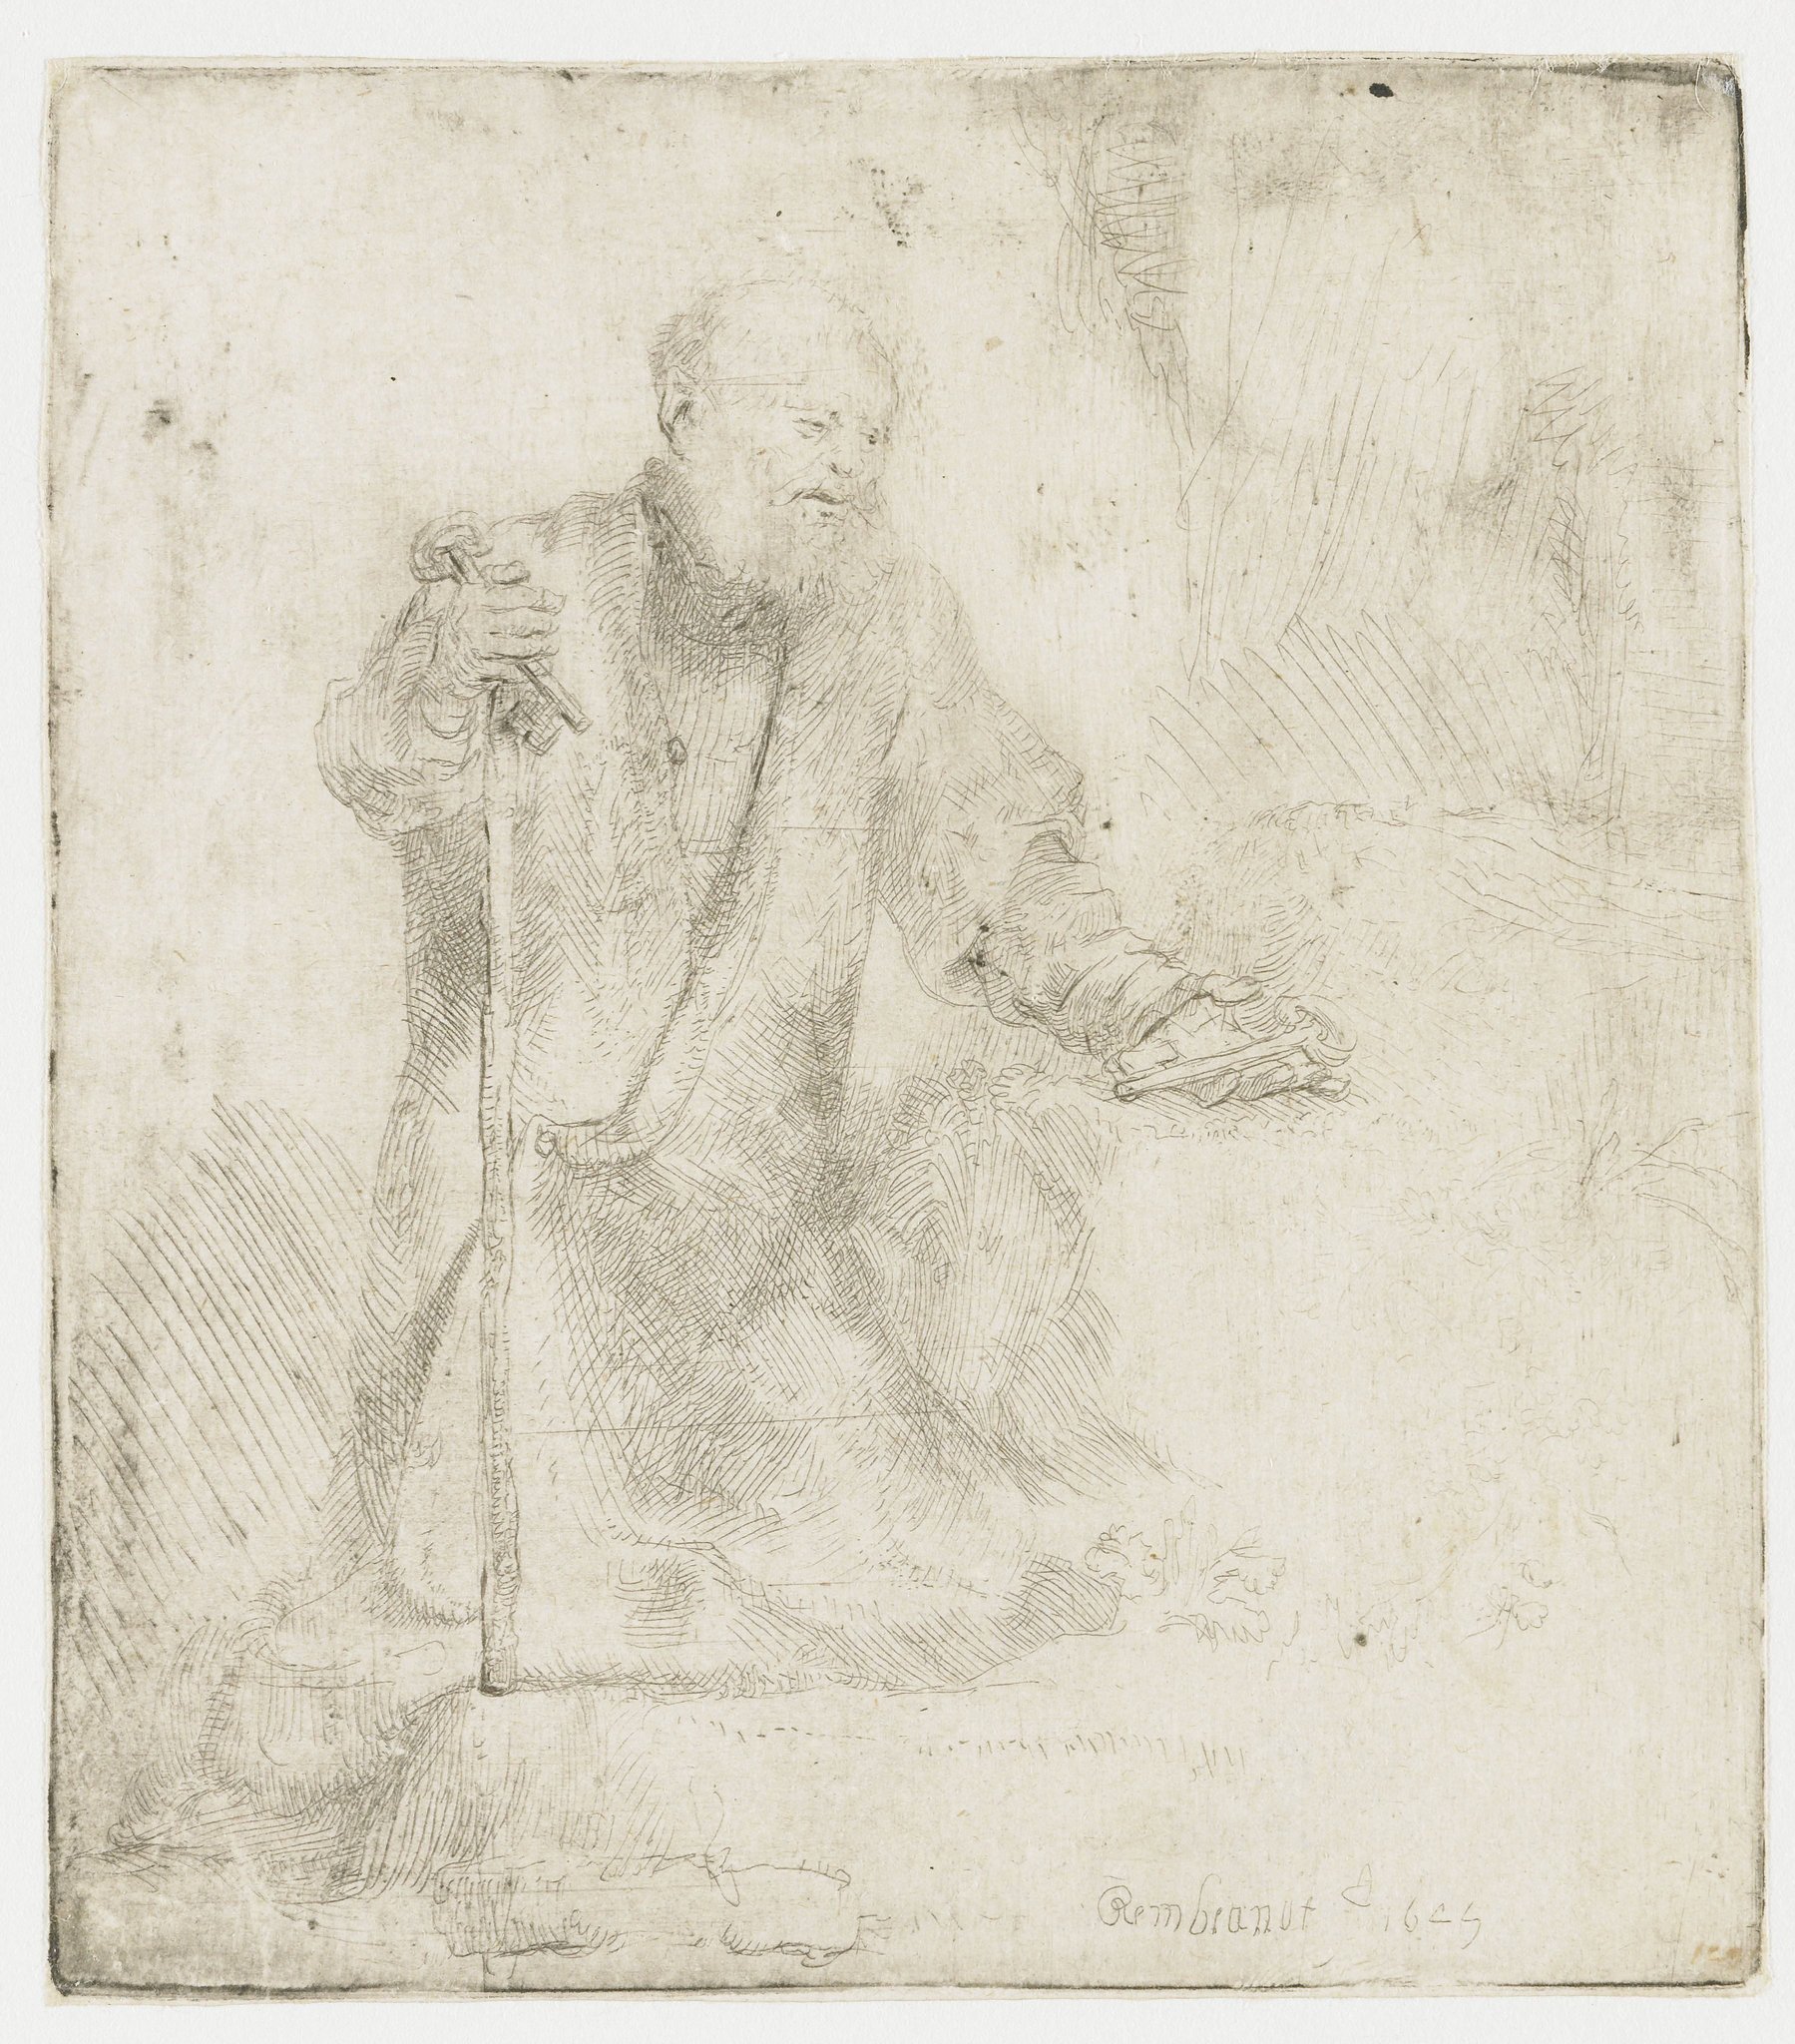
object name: print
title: St Peter in penitence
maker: rembrandt van rijn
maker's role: draughtsman, painter, print maker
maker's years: 1606-1669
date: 1645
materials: paper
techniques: etching, intaglio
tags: story of the denial of peter (matthew 26:58, 26:69-75; mark 14:54, 14:66-72; luke 22:55-62; john 18:15-18, 18:25-27)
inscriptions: inscription: ‘f 25’, signature and date: ‘Rembrandt f 1645’, inscription: ‘4 stu(?)’